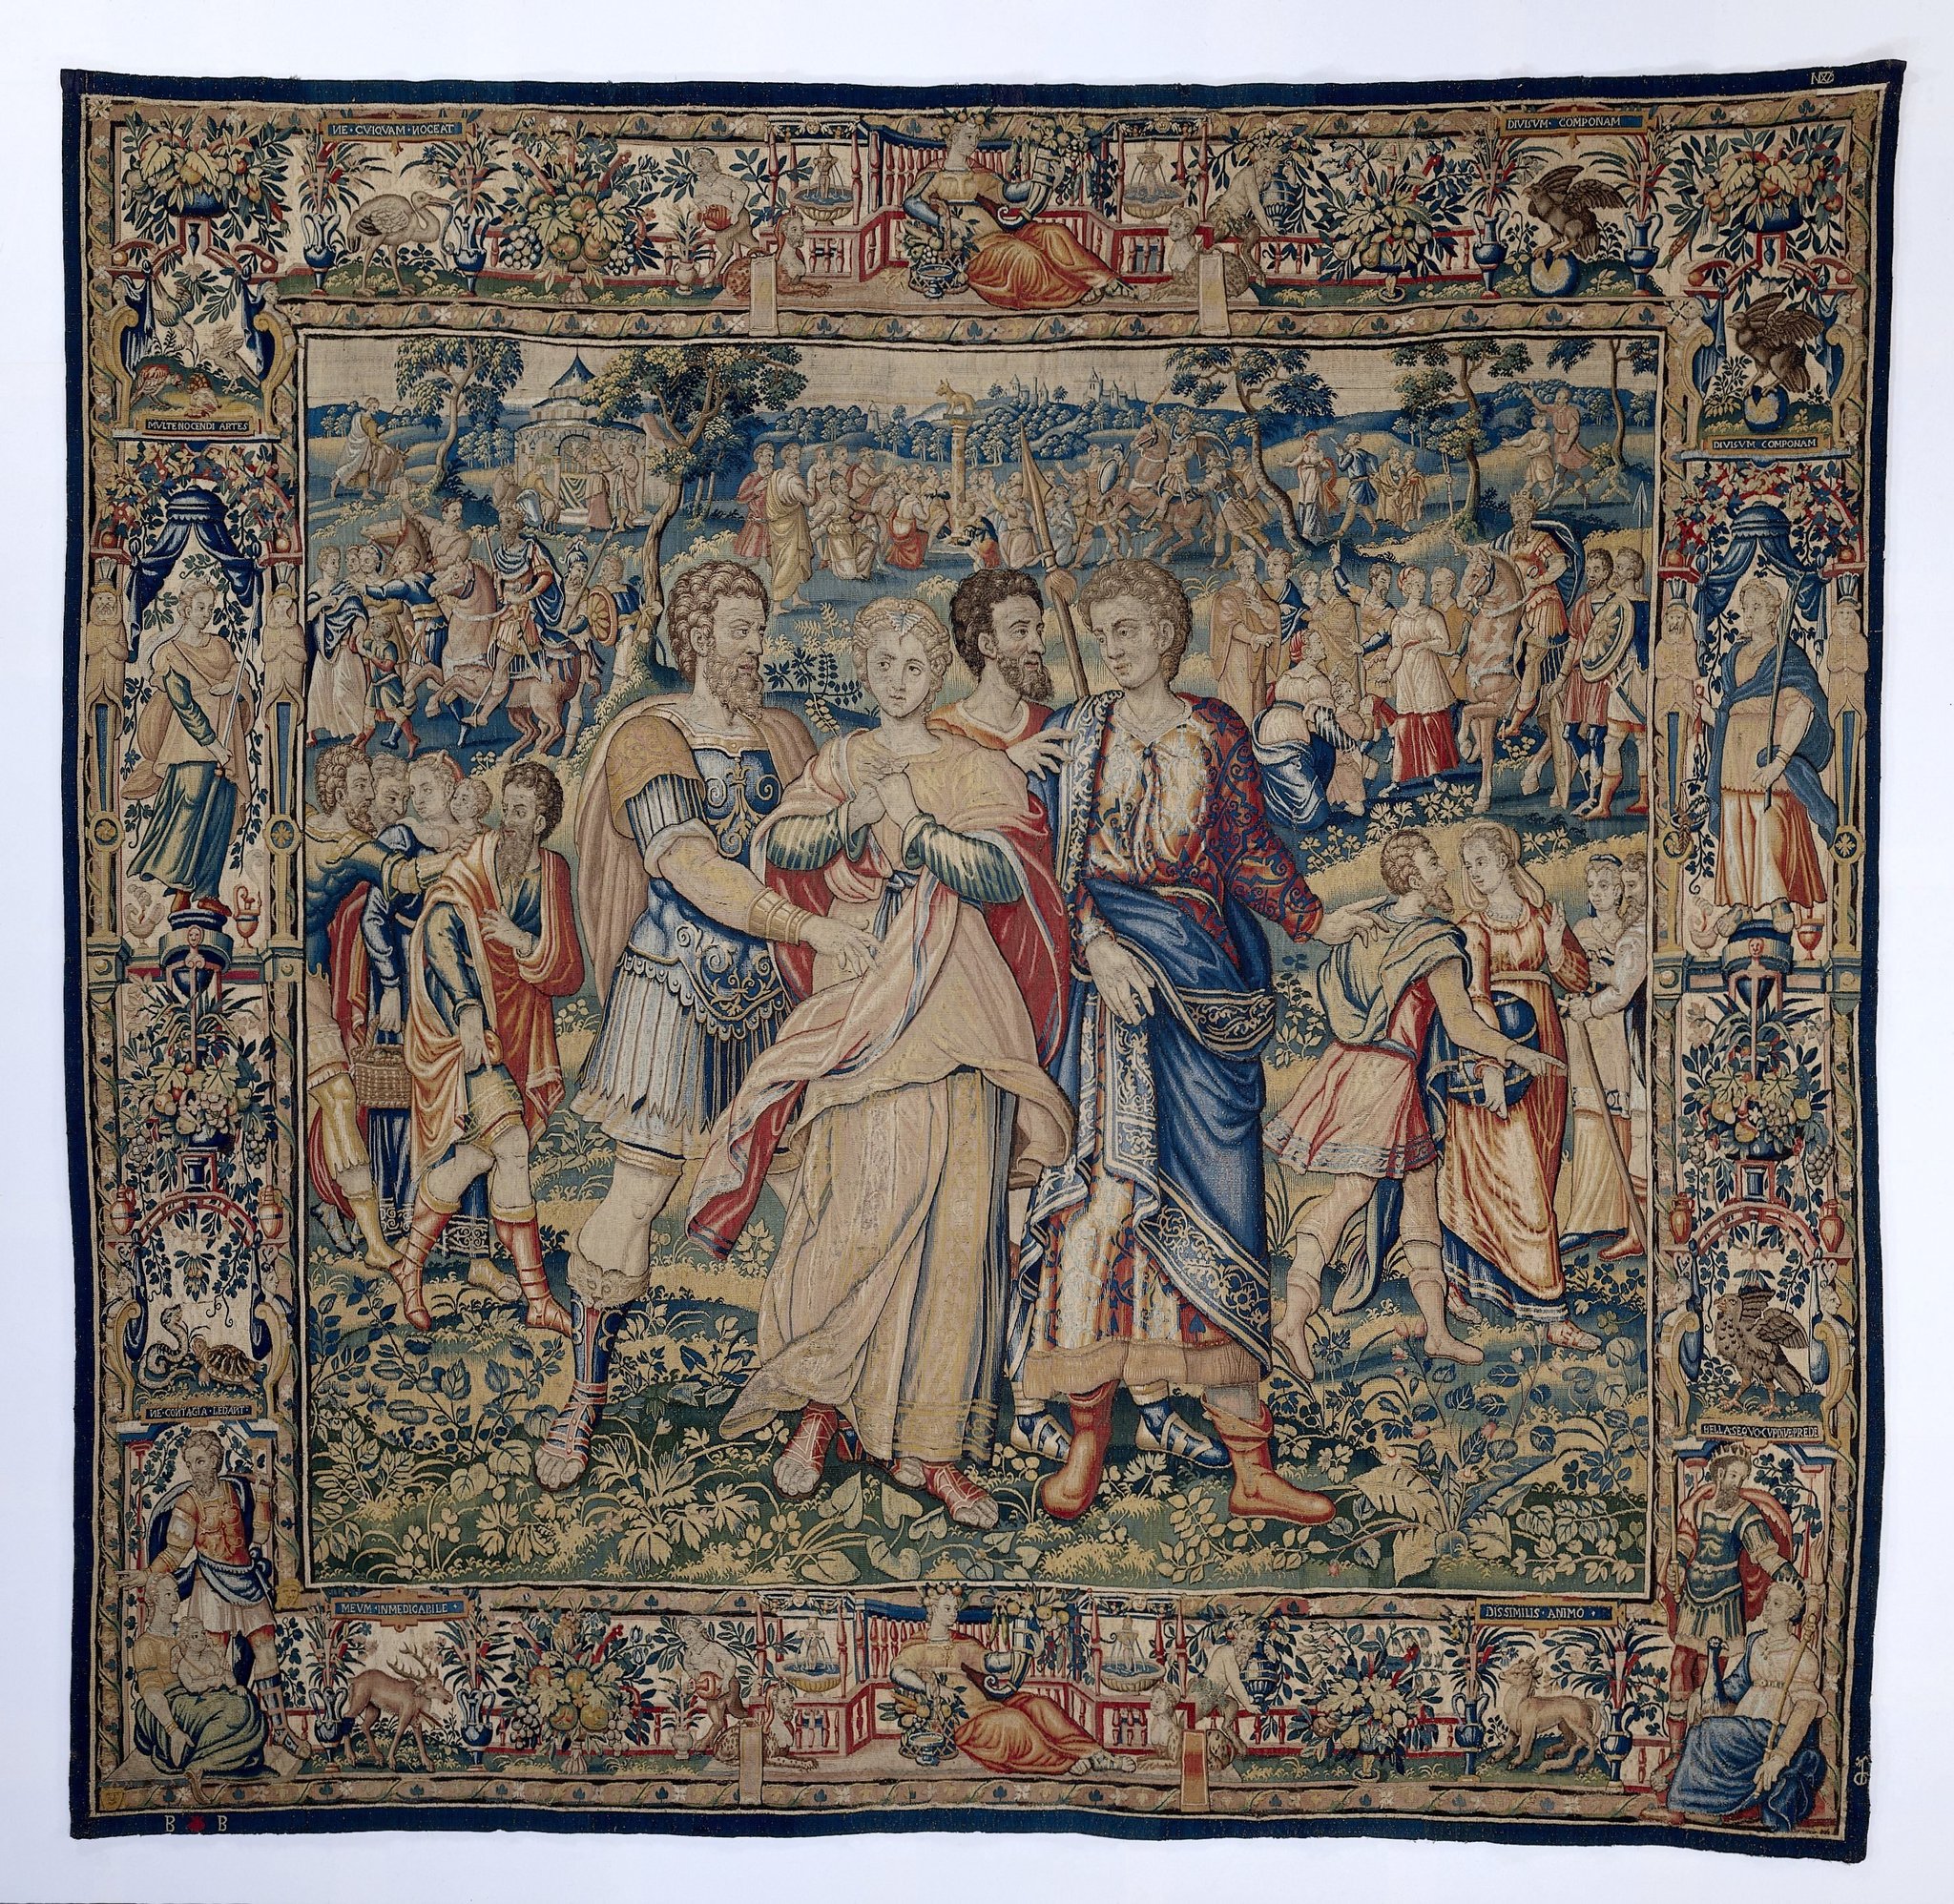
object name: tapestry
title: Tobit en Anna in ballingschap naar Ninevé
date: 1560-1575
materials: silk, wool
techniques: tapestry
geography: brussels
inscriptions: mark: ‘Frans Goebels’, mark: ‘Brussel’, mark: ‘NDW’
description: Wandtapijt met de Babylonische Ballingschap geprofeteerd door Jeremia (2 Kronieken 36:20-21) na de verwoesting van Jeruzalem door Nebukadnezar. Gemerkt met een weversmerk en het Brusselse stadswapen.